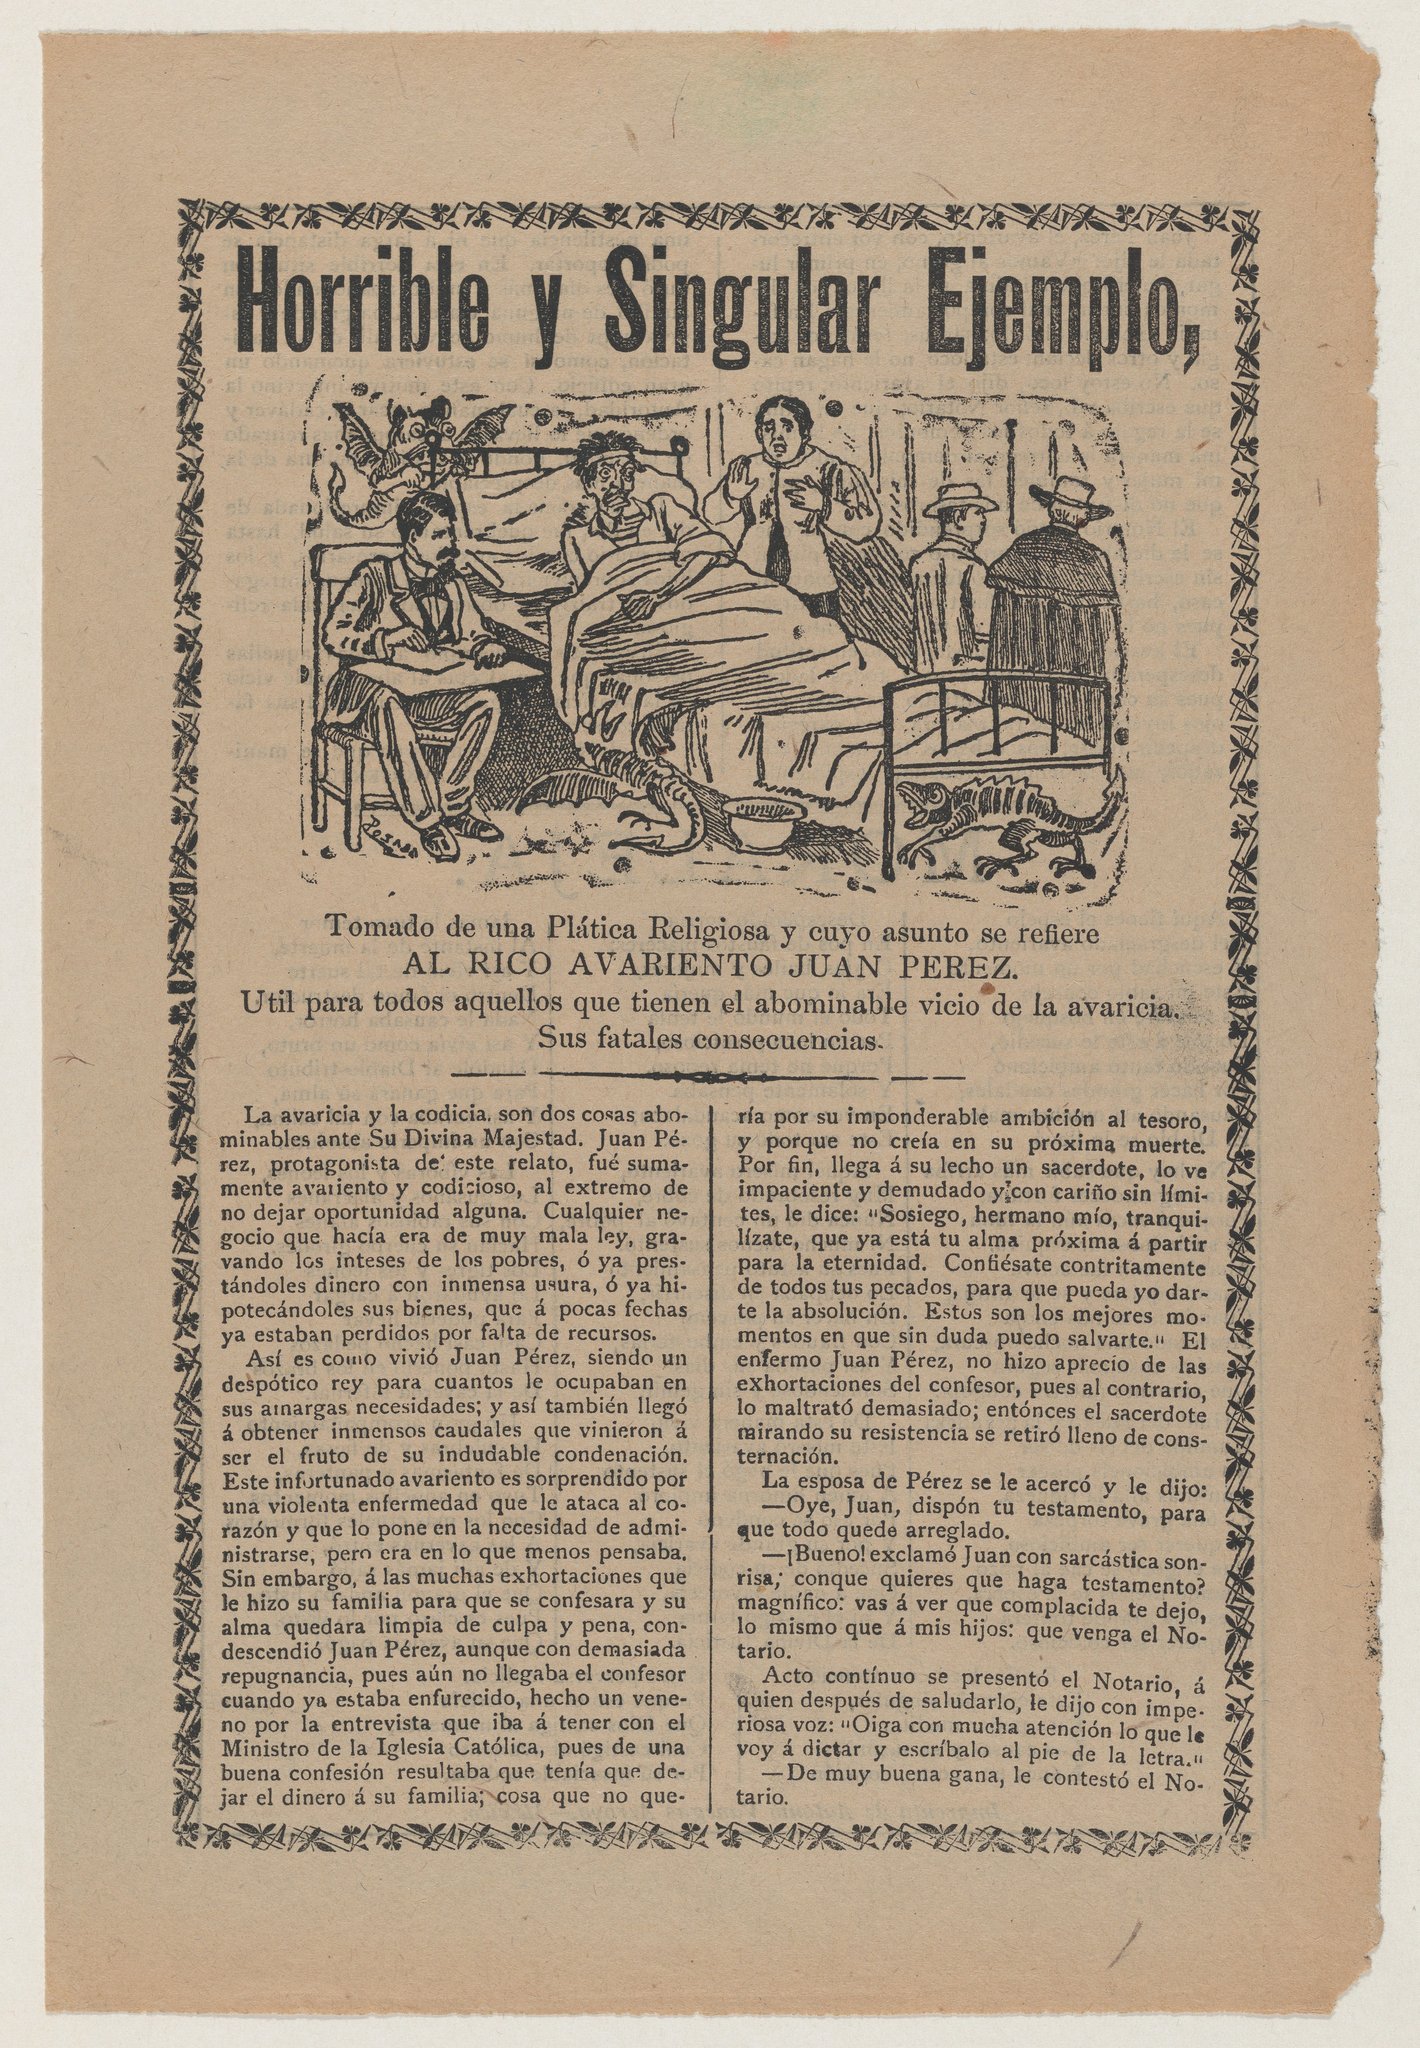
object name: print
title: Broadsheet relating to the greed of Juan Pérez and his ill-gotten financial gains through dishonesty, abusing the poor, and swindling the church, a description in the bottom section continuing on verso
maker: josé guadalupe posada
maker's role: artist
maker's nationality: mexican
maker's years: 1852-1913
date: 1900-1910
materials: paper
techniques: letterpress, lithography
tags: men,women